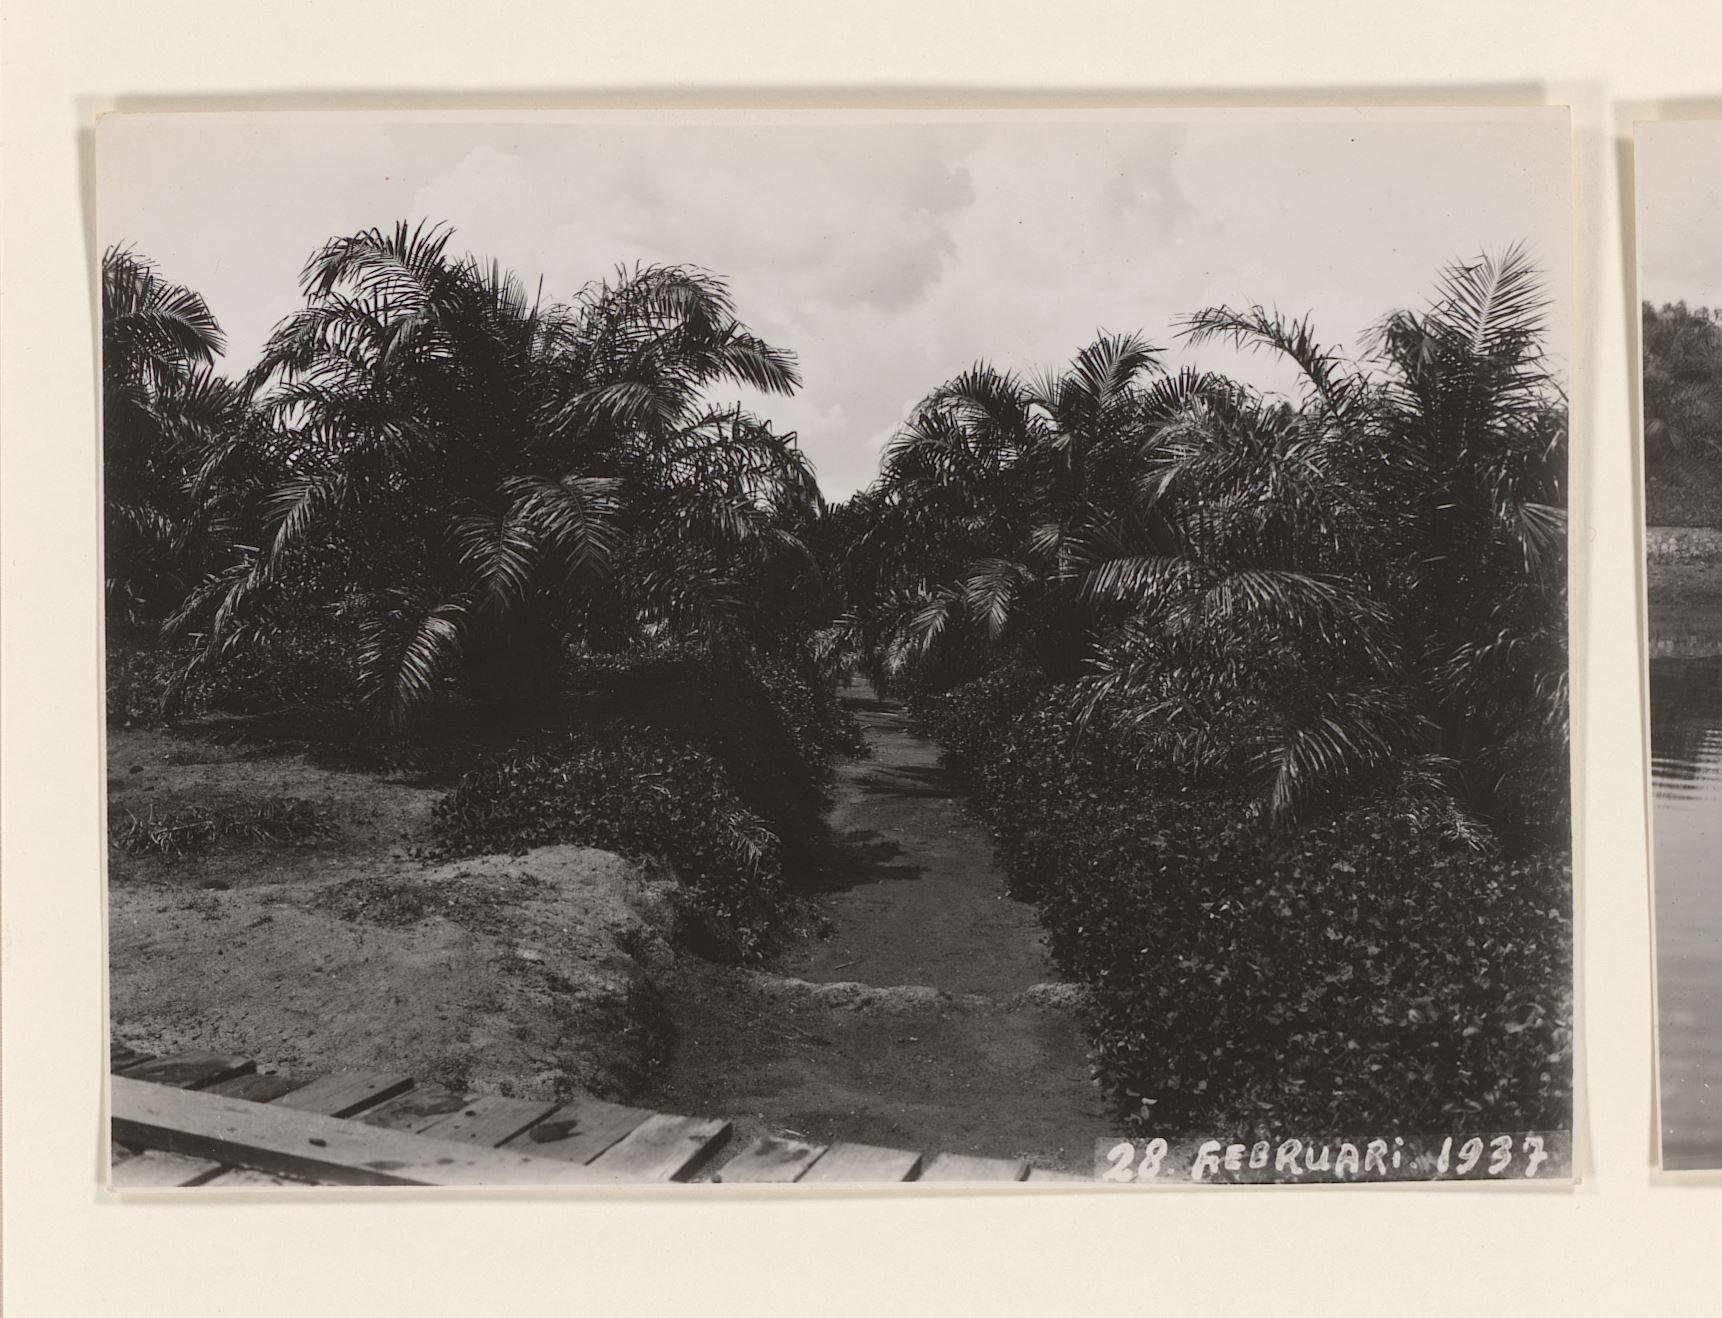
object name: photograph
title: Watervoorziening op Padang Halaban, 1937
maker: shibaya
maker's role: fotograaf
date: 1937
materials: photographic support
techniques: gelatin silver print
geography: sumatra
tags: plantation, (non-fruit) products of plants or trees: palm oil, sumatra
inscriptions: name: ‘Shibaya R. Prapat’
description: Watervoorziening voor de oliepalmen op Padang Halaban, februari 1937. Tweede afdruk, los in melinexhoesje, van een foto ingeplakt op albumblad 3. Onderdeel van het fotoalbum over de plantages Pernantian en Brussel van de Sumatra Caoutchouc Maatschappij op de Oostkust van Sumatra in de jaren 1935-1939.